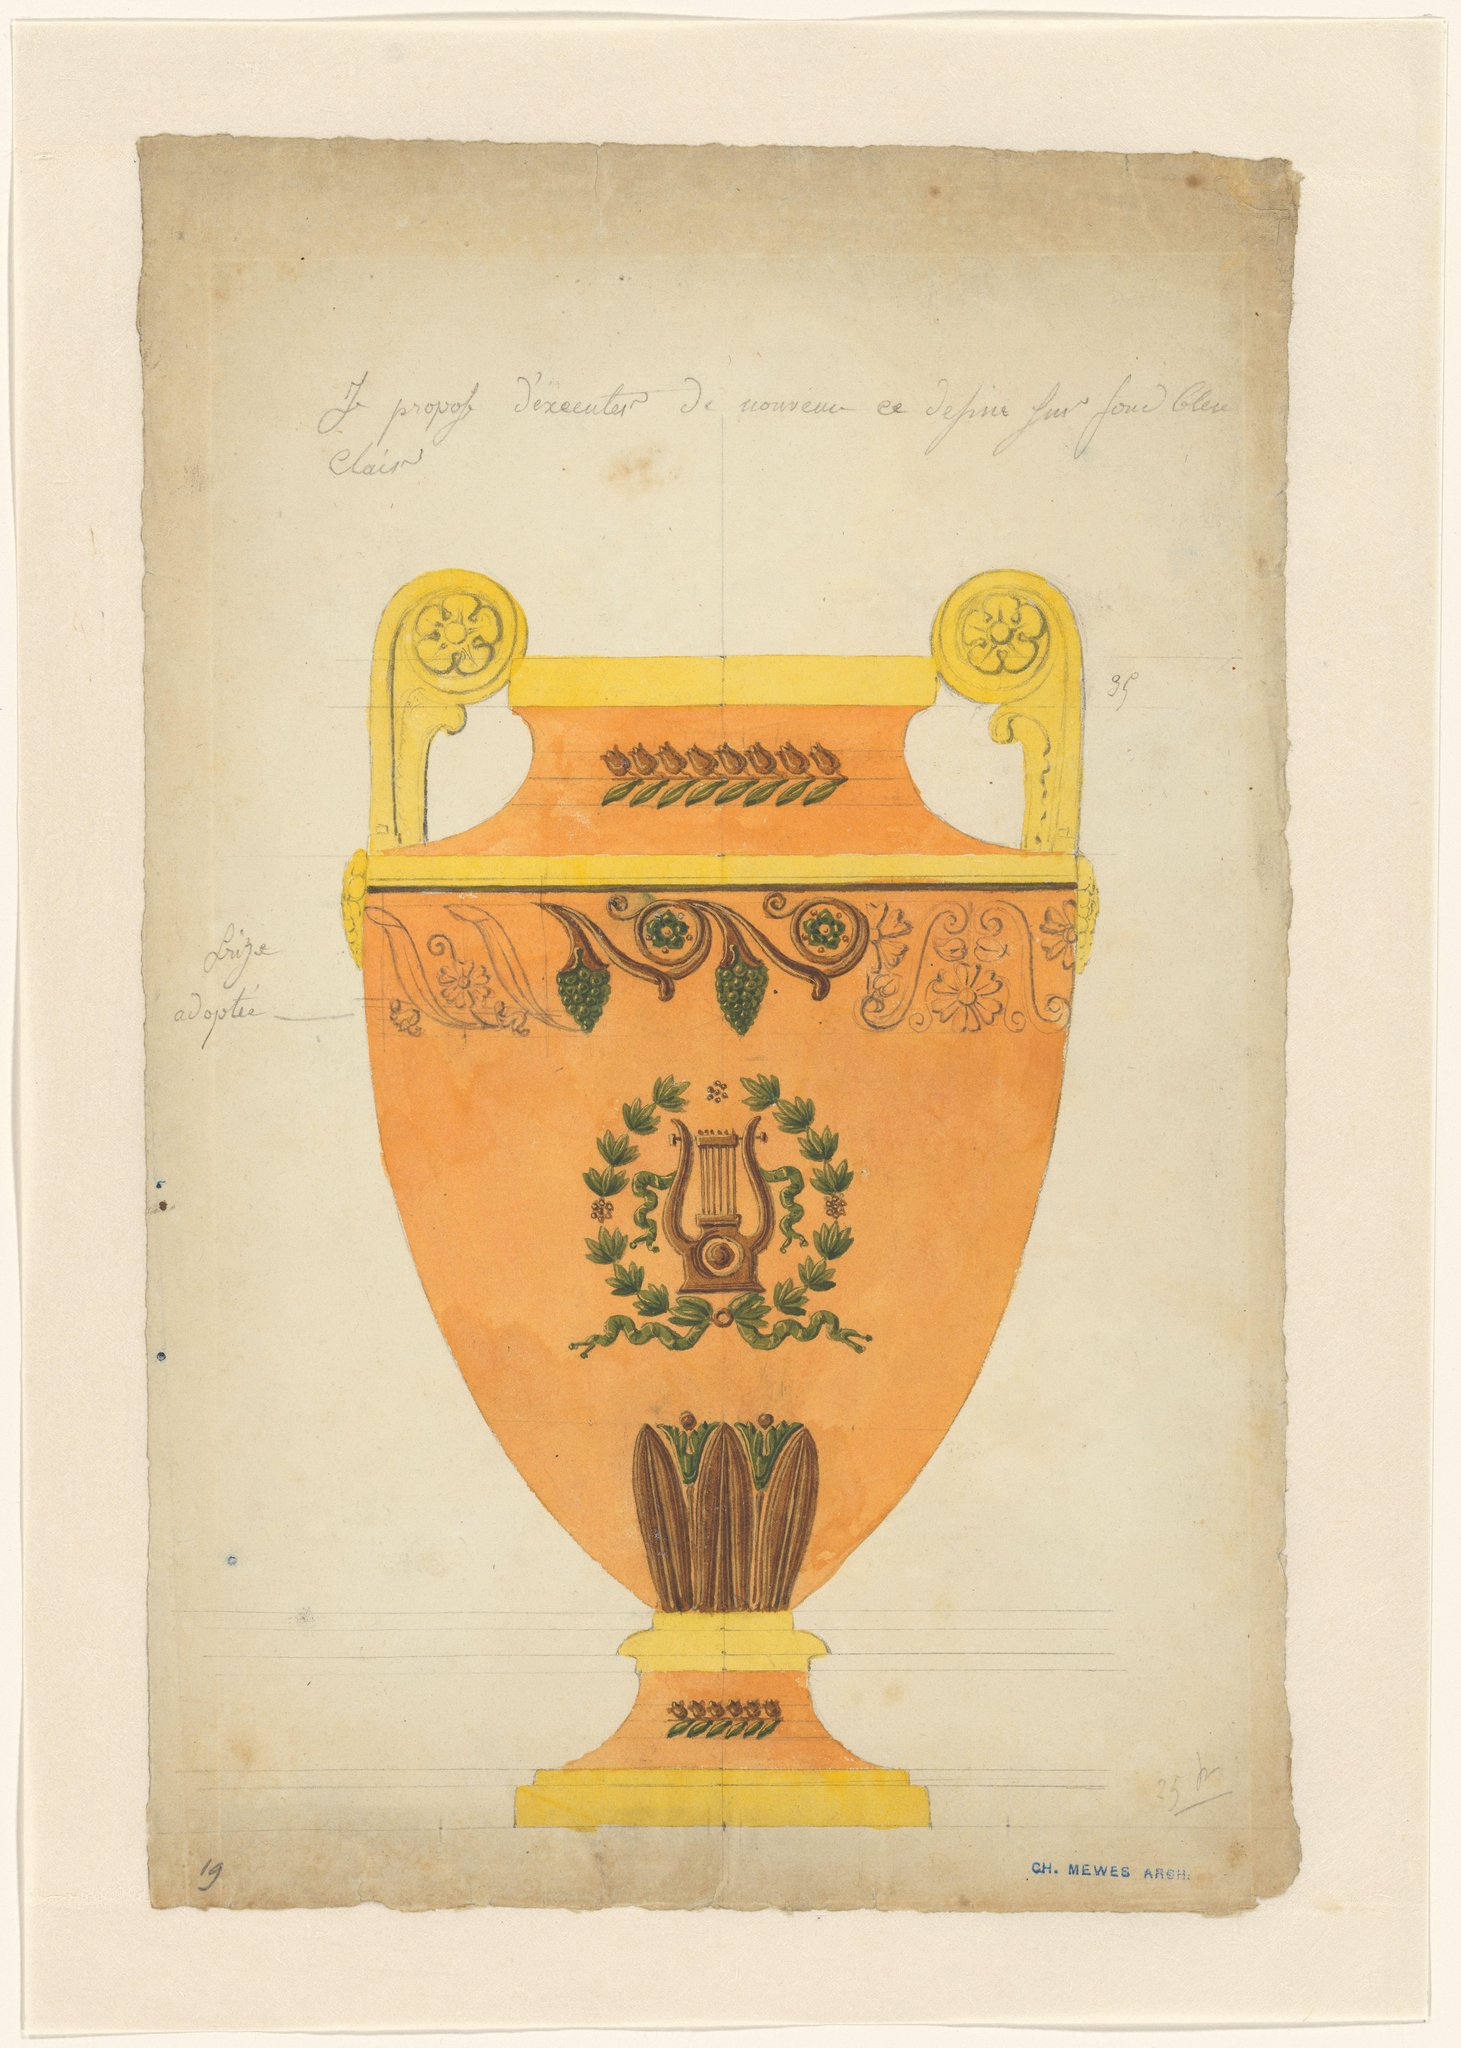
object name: design drawing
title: Ontwerp voor een vaas van Sèvres porselein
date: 1805-1815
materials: chalk, gold, graphite, paper, watercolor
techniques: aquarelle, drawing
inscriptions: watermark: ‘palmet’, inscription: ‘Je propose d’executer de nouveau ce dessein sur fond bleu clair / 3G / frize adoptée / 25 fr / 19’, collector's mark: Lugt 4173